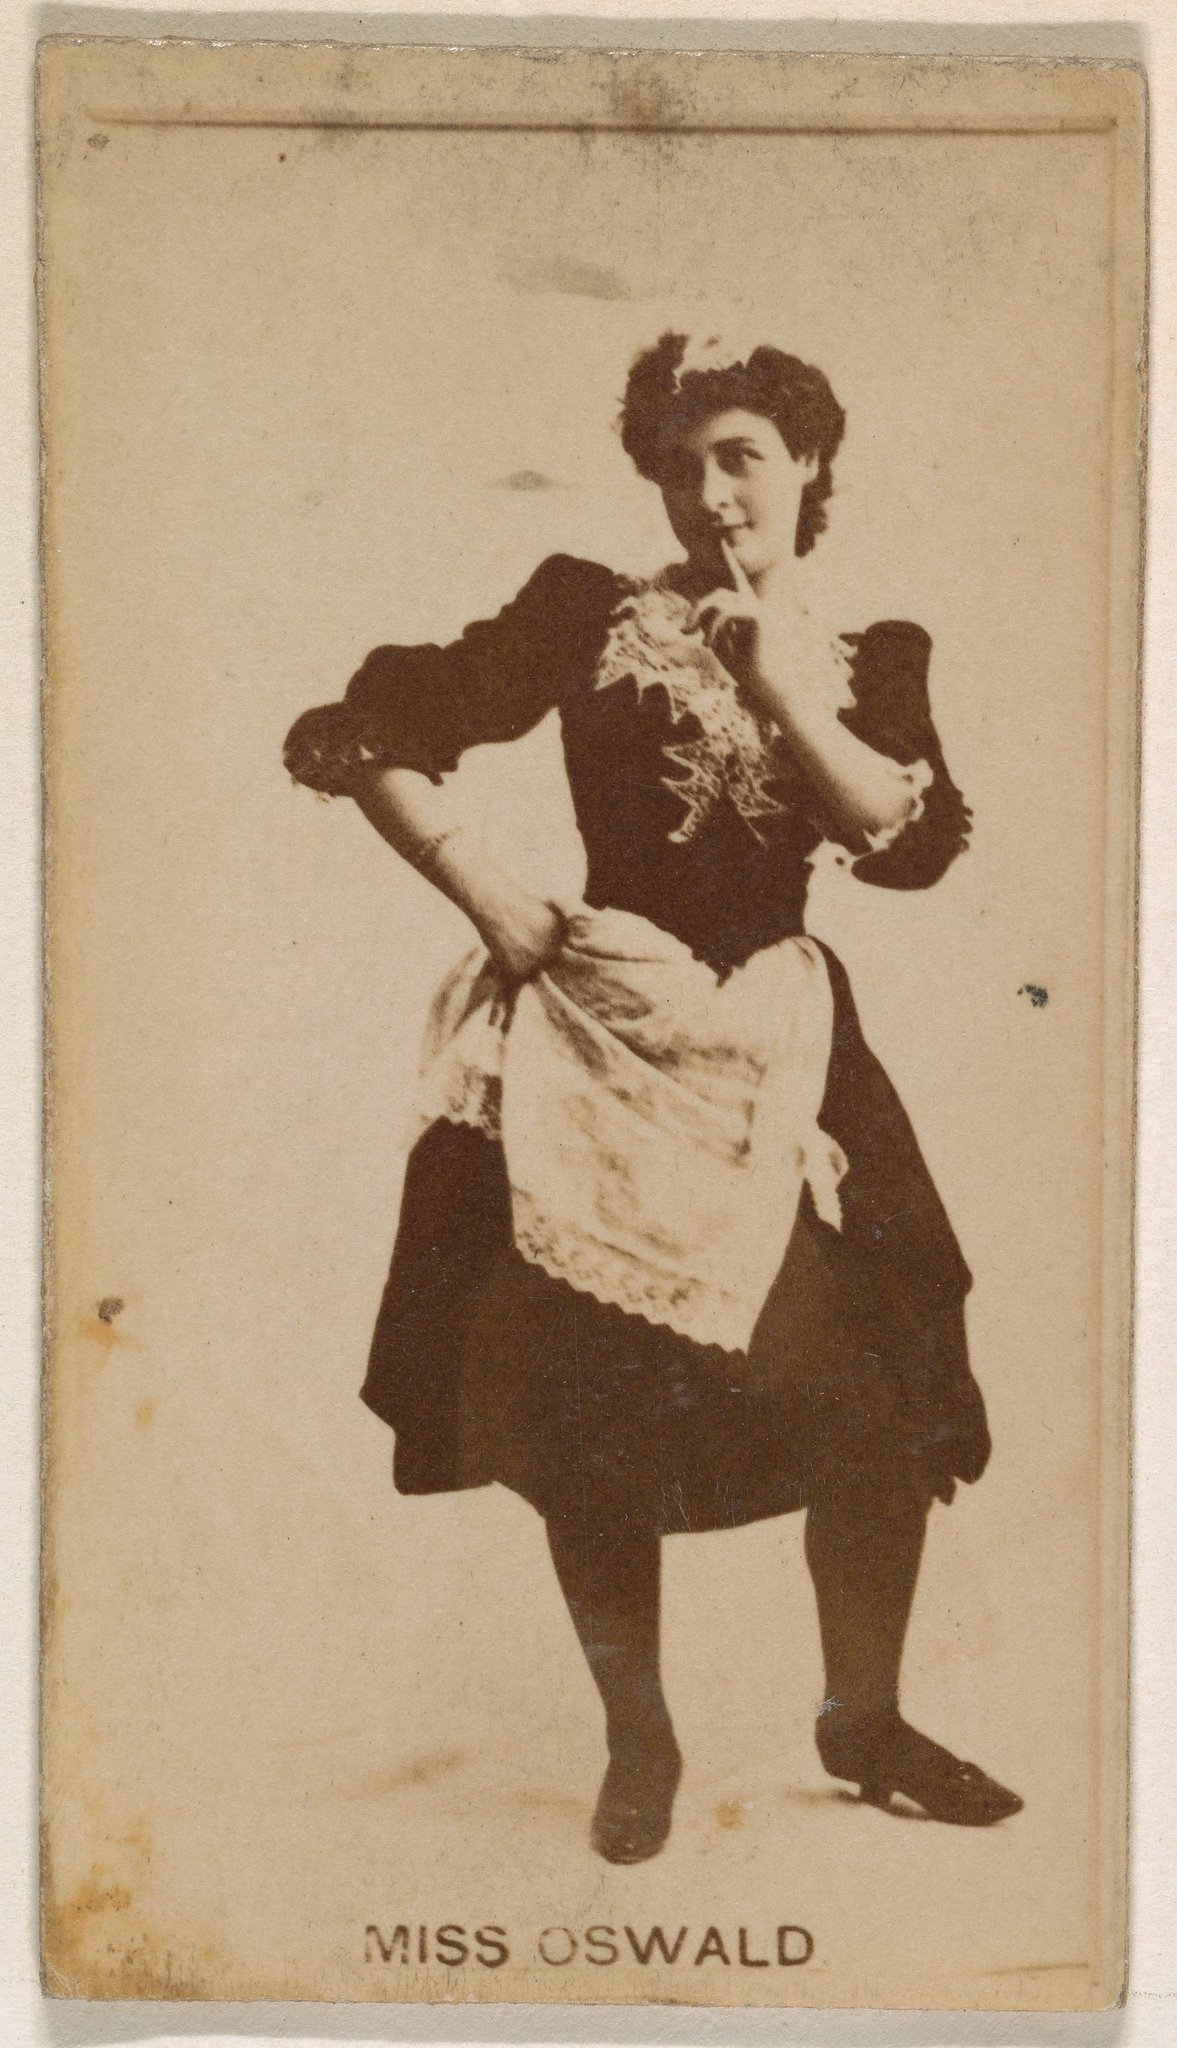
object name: photograph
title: Miss Oswald, from the Actresses series (N245) issued by Kinney Brothers to promote Sweet Caporal Cigarettes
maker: kinney brothers tobacco company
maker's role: publisher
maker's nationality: american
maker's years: 1869-2011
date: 1890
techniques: albumen silver print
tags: portraits,women,actresses